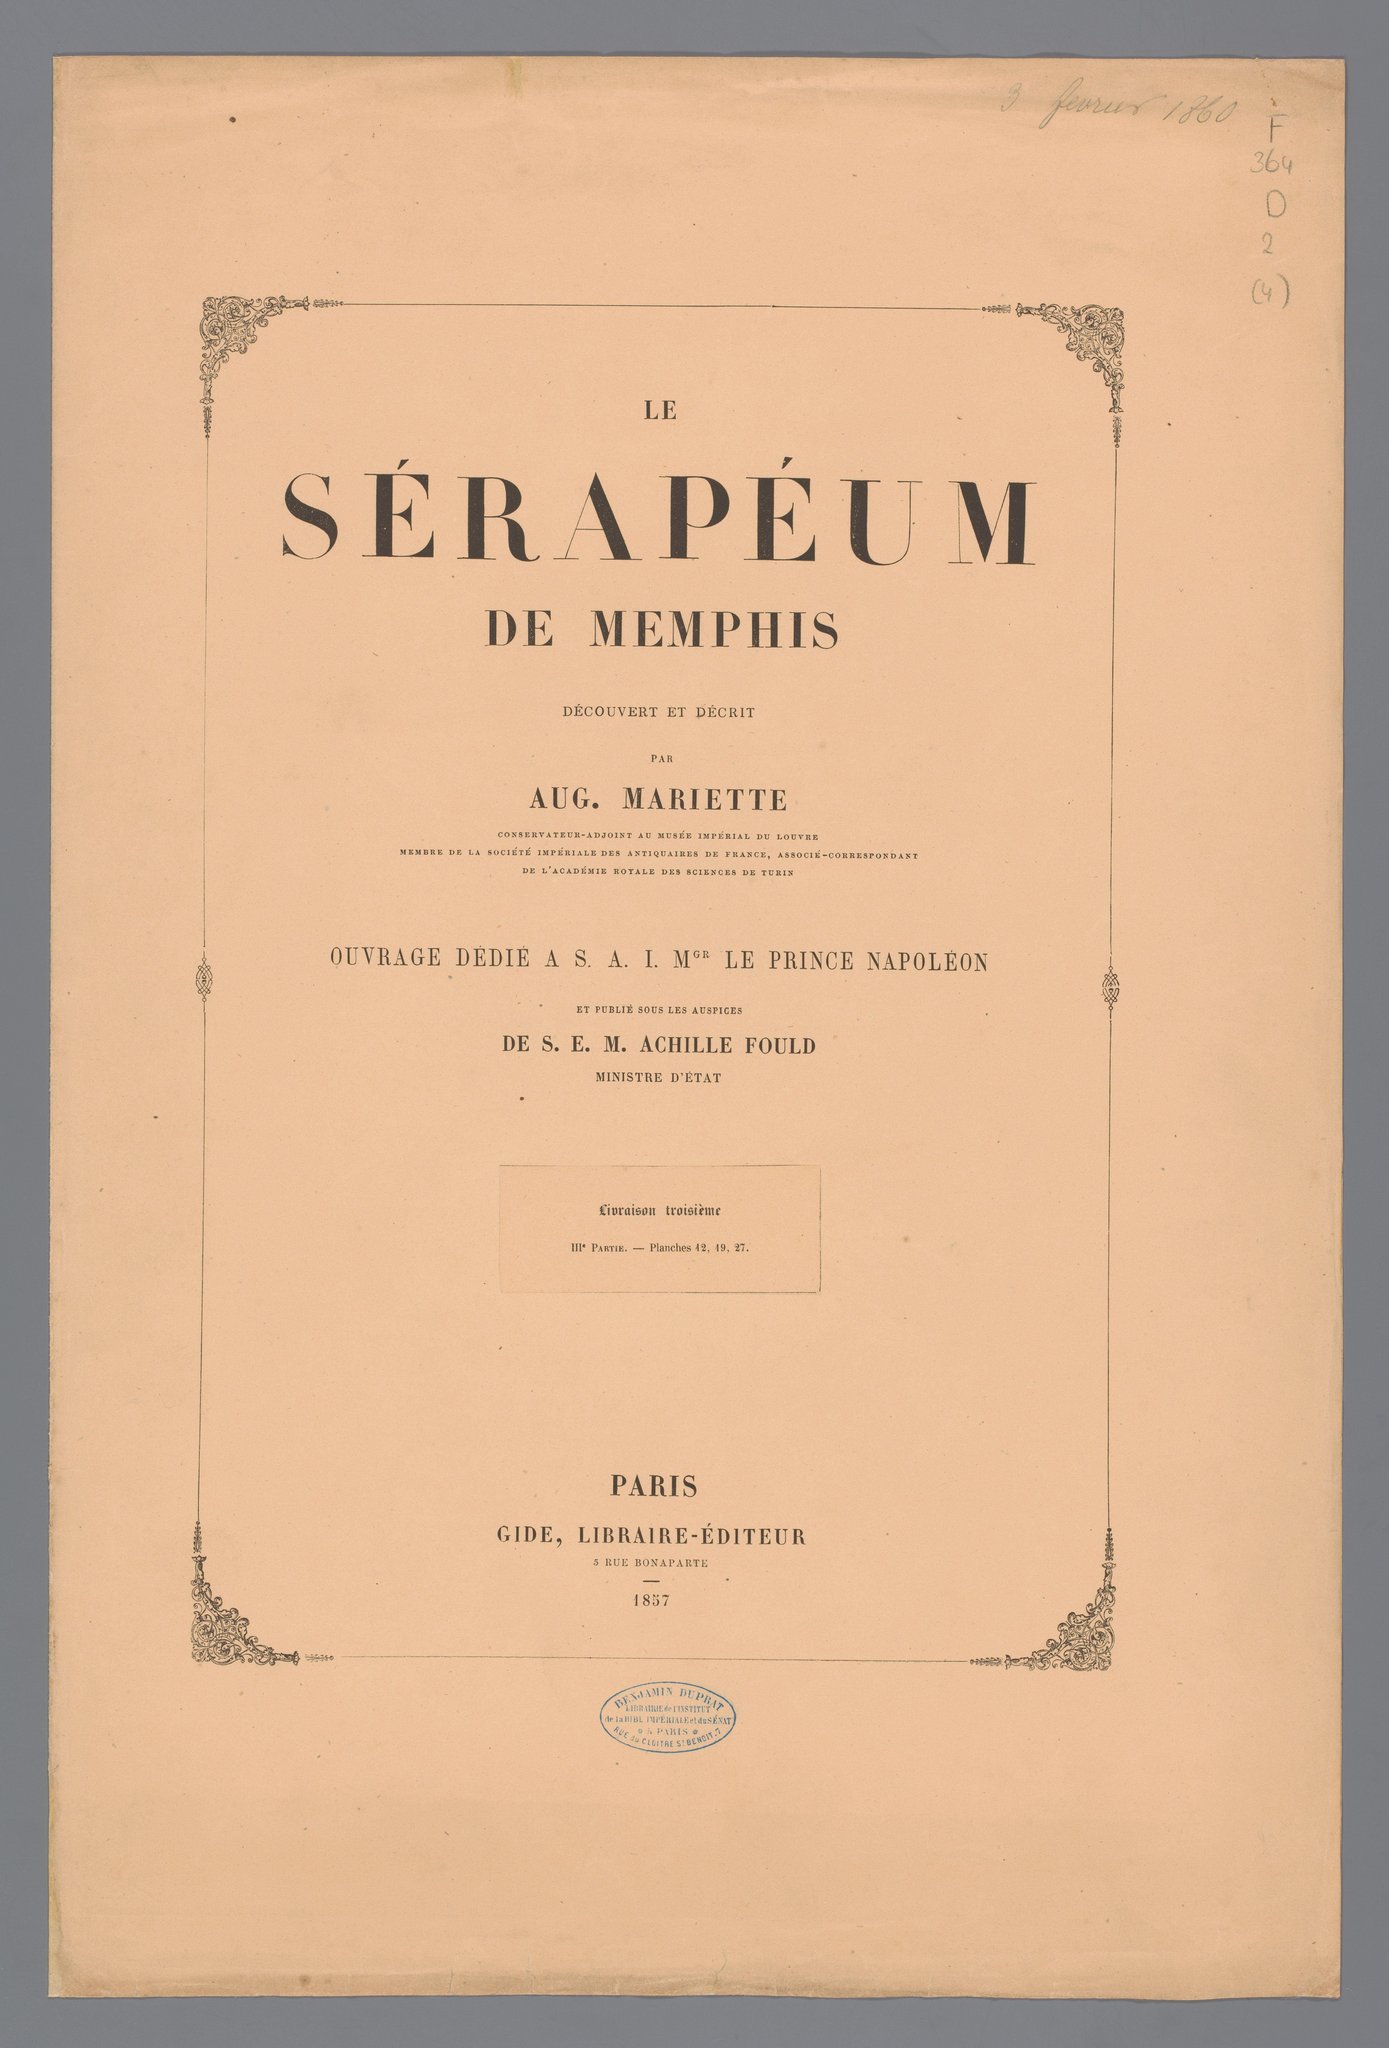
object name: wrapper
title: Le Sérapéum de Memphis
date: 1857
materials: cardboard, paper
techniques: photograph, printing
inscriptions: collector's mark: ‘Benjamin Duprat/ Libraire de L'Institut (...)’, annotation: ‘3 fevrier 1860’